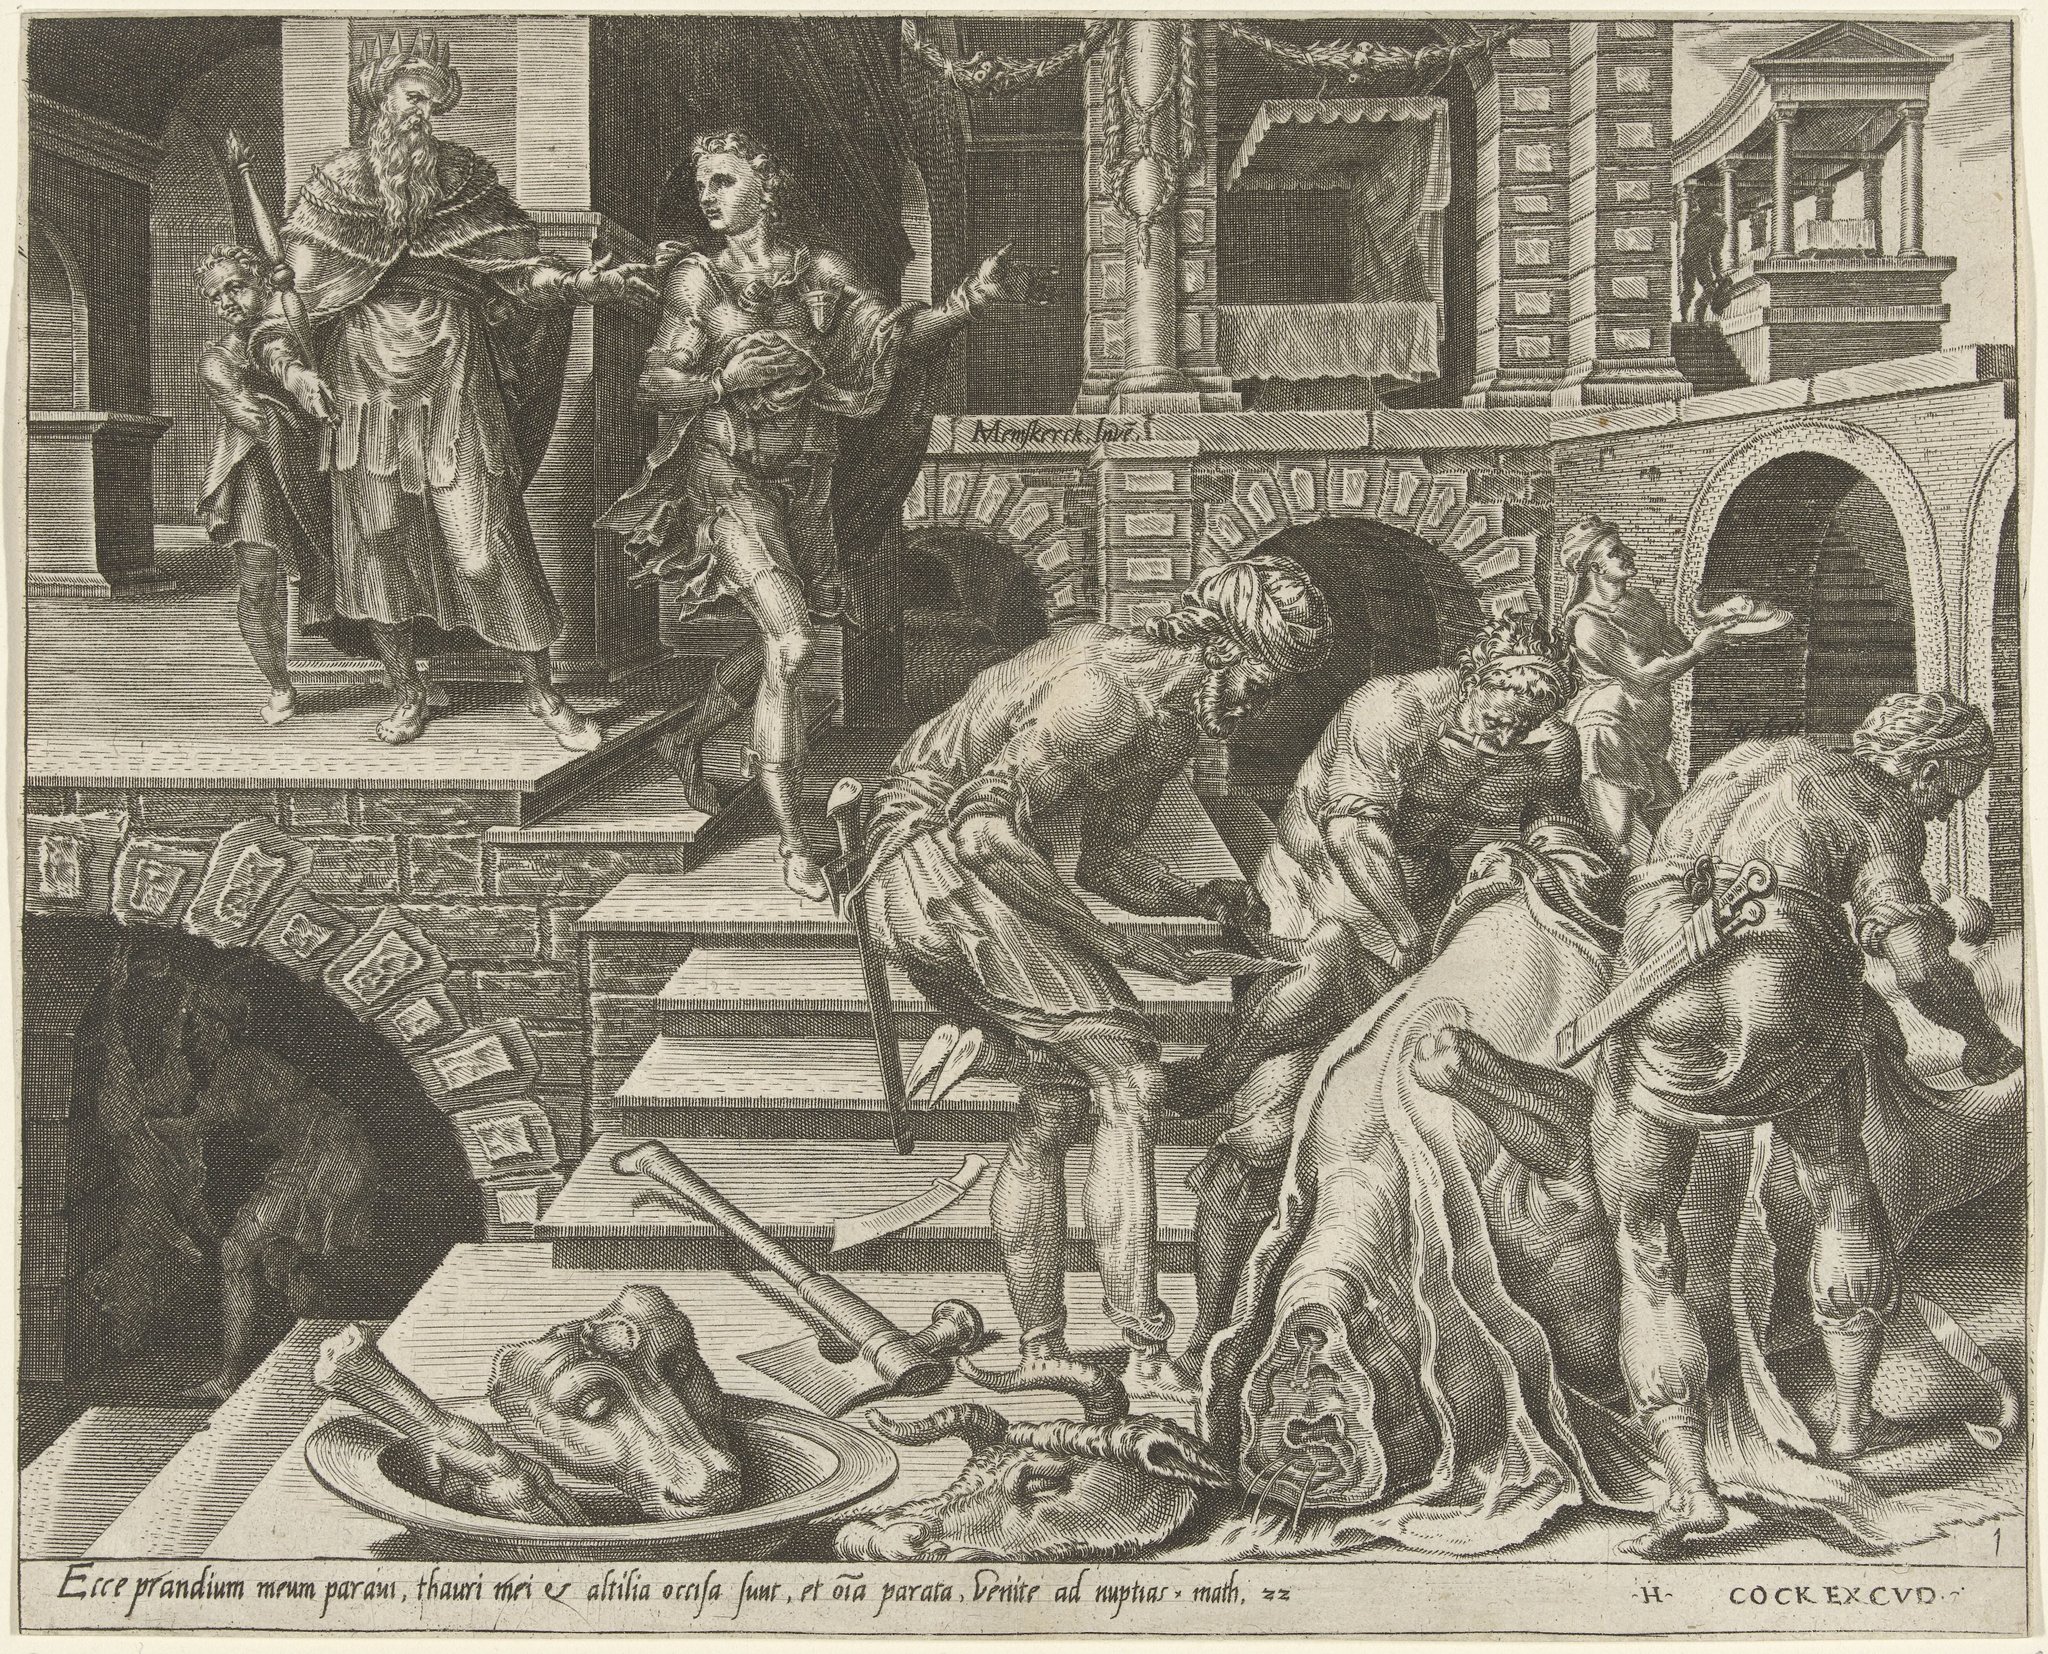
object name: print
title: Voorbereidingen voor het bruiloftsfeest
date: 1558-1559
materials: paper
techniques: engraving, etching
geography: haarlem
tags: first invitation to the feast ~ parable of the royal wedding-feast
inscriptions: collector's mark: Lugt 2228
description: De voorbereidingen voor het banket. De koning heeft zijn beste mestvee laten slachten. Hij stuurt zijn dienaren erop uit om de gasten uit te nodigen. De prent heeft een Latijns onderschrift en maakt deel uit van een zesdelige serie over de gelijkenis van een bruiloftsfeest.